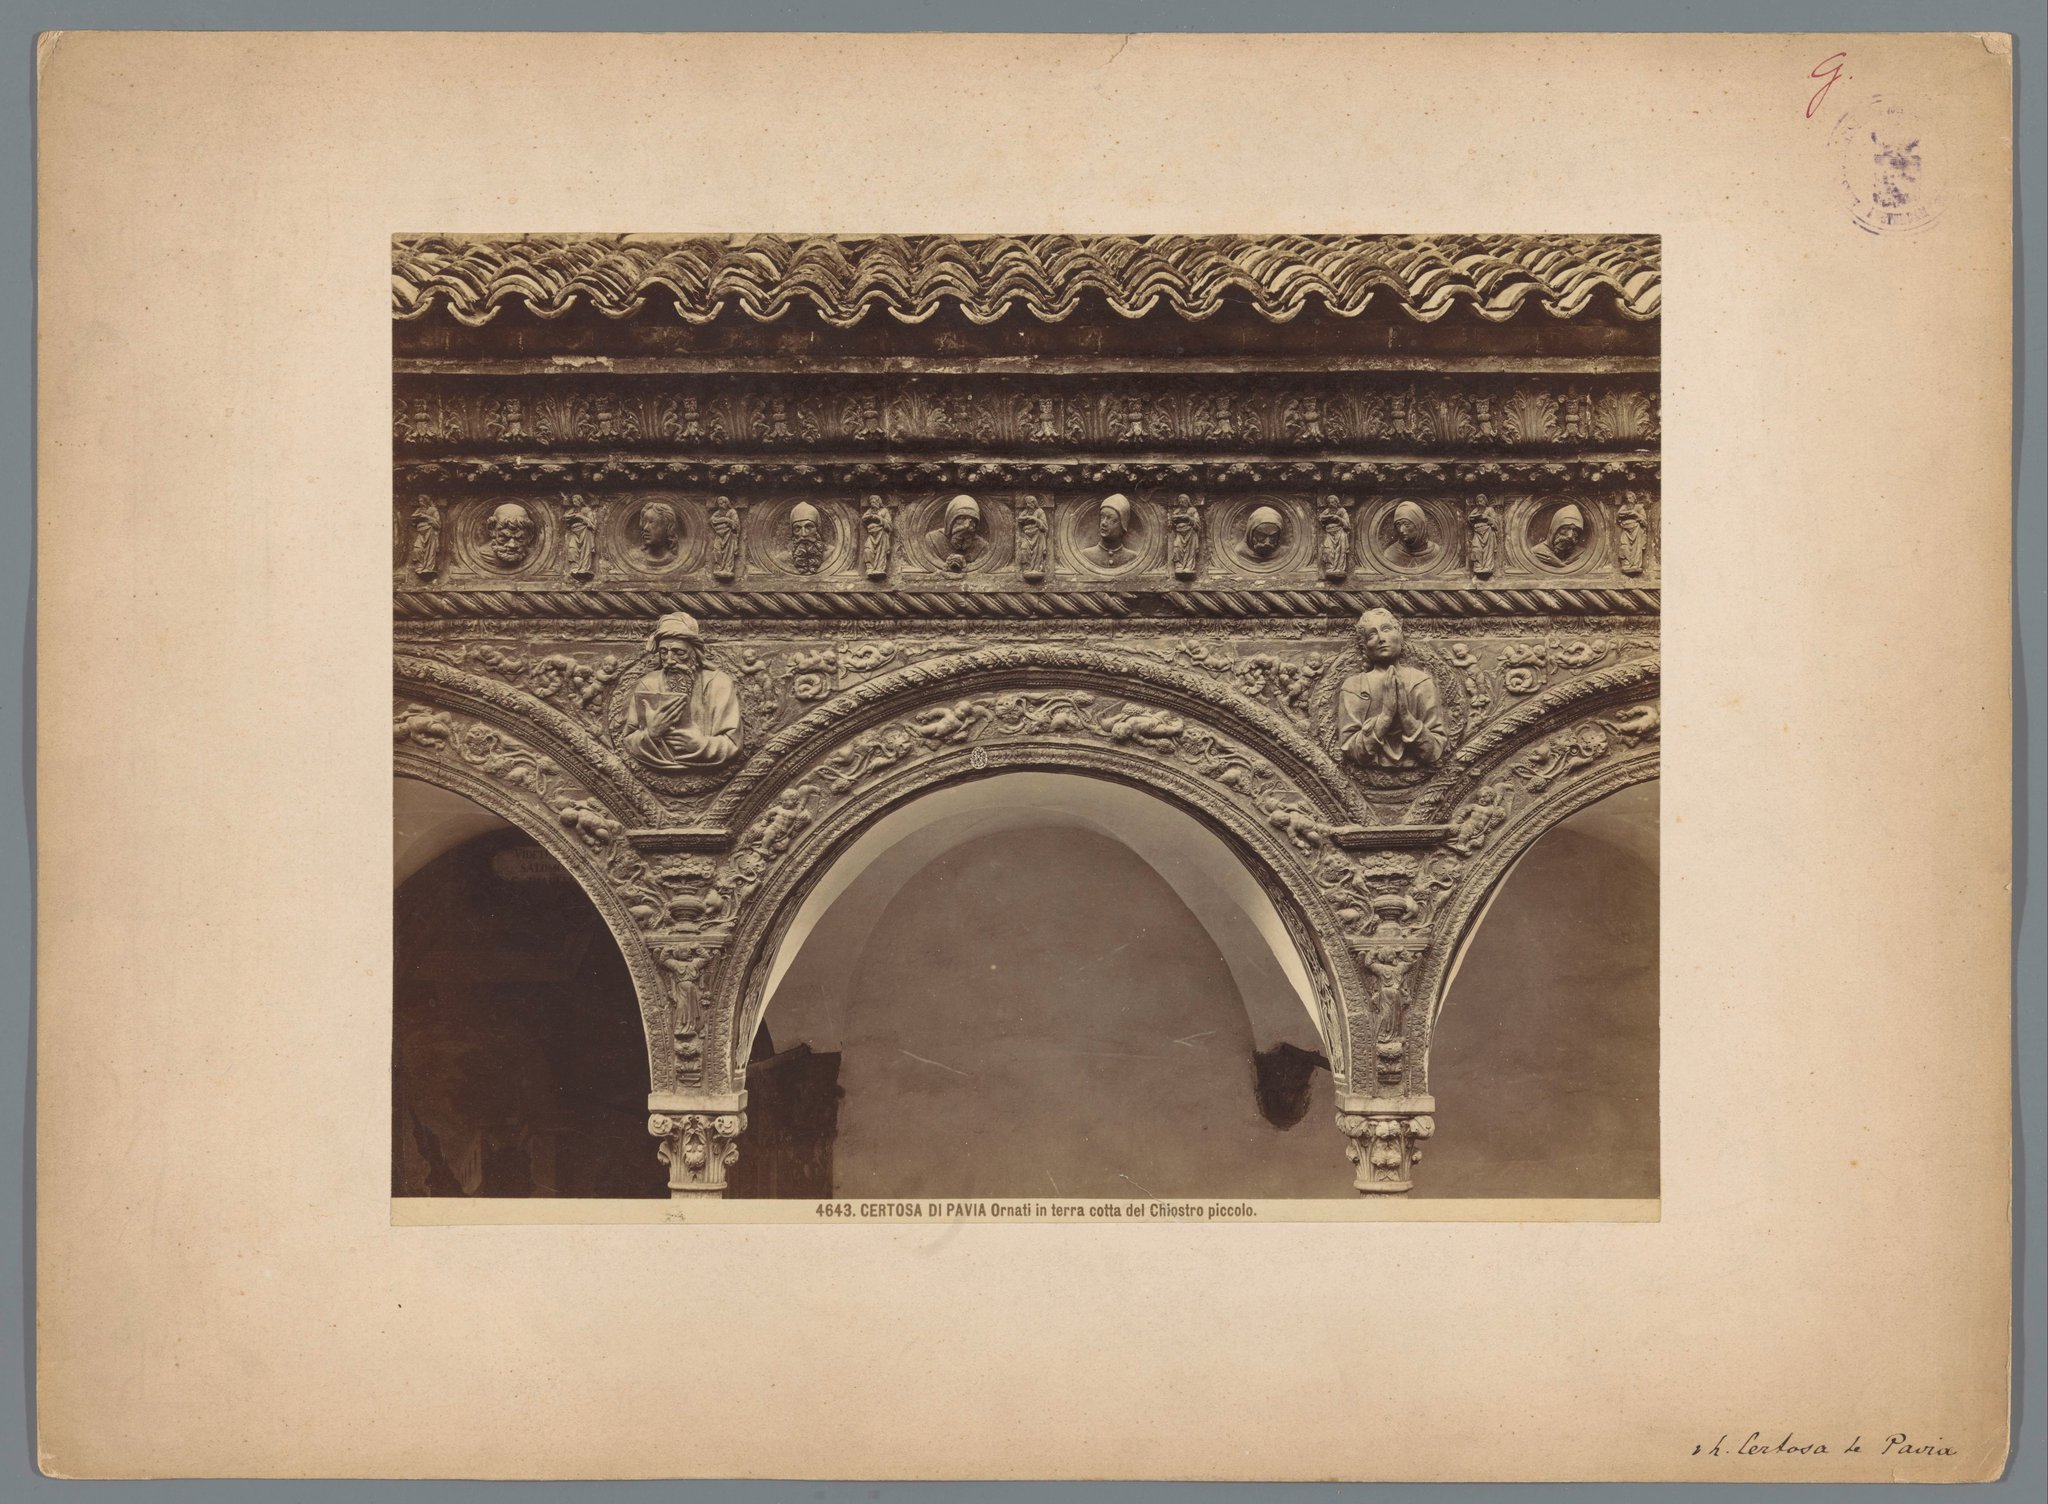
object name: photograph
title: CERTOSA DI PAVIA Ornati in terra cotta del Chiostro piccolo.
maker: Anonymous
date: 1875-1900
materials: cardboard, photographic support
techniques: albumen print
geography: certosa di pavia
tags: arch, archivolt ~ architecture, cloisters ~ monastery, sculpture (+ relief ~ sculpture)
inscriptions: number: ‘4643.’, collector's mark: ‘RIJKS-NORMAALSCHOOL voor TEEKENONDERWIJZERS AMSTERDAM’, inscription: ‘i h. Certosa te Pavia’